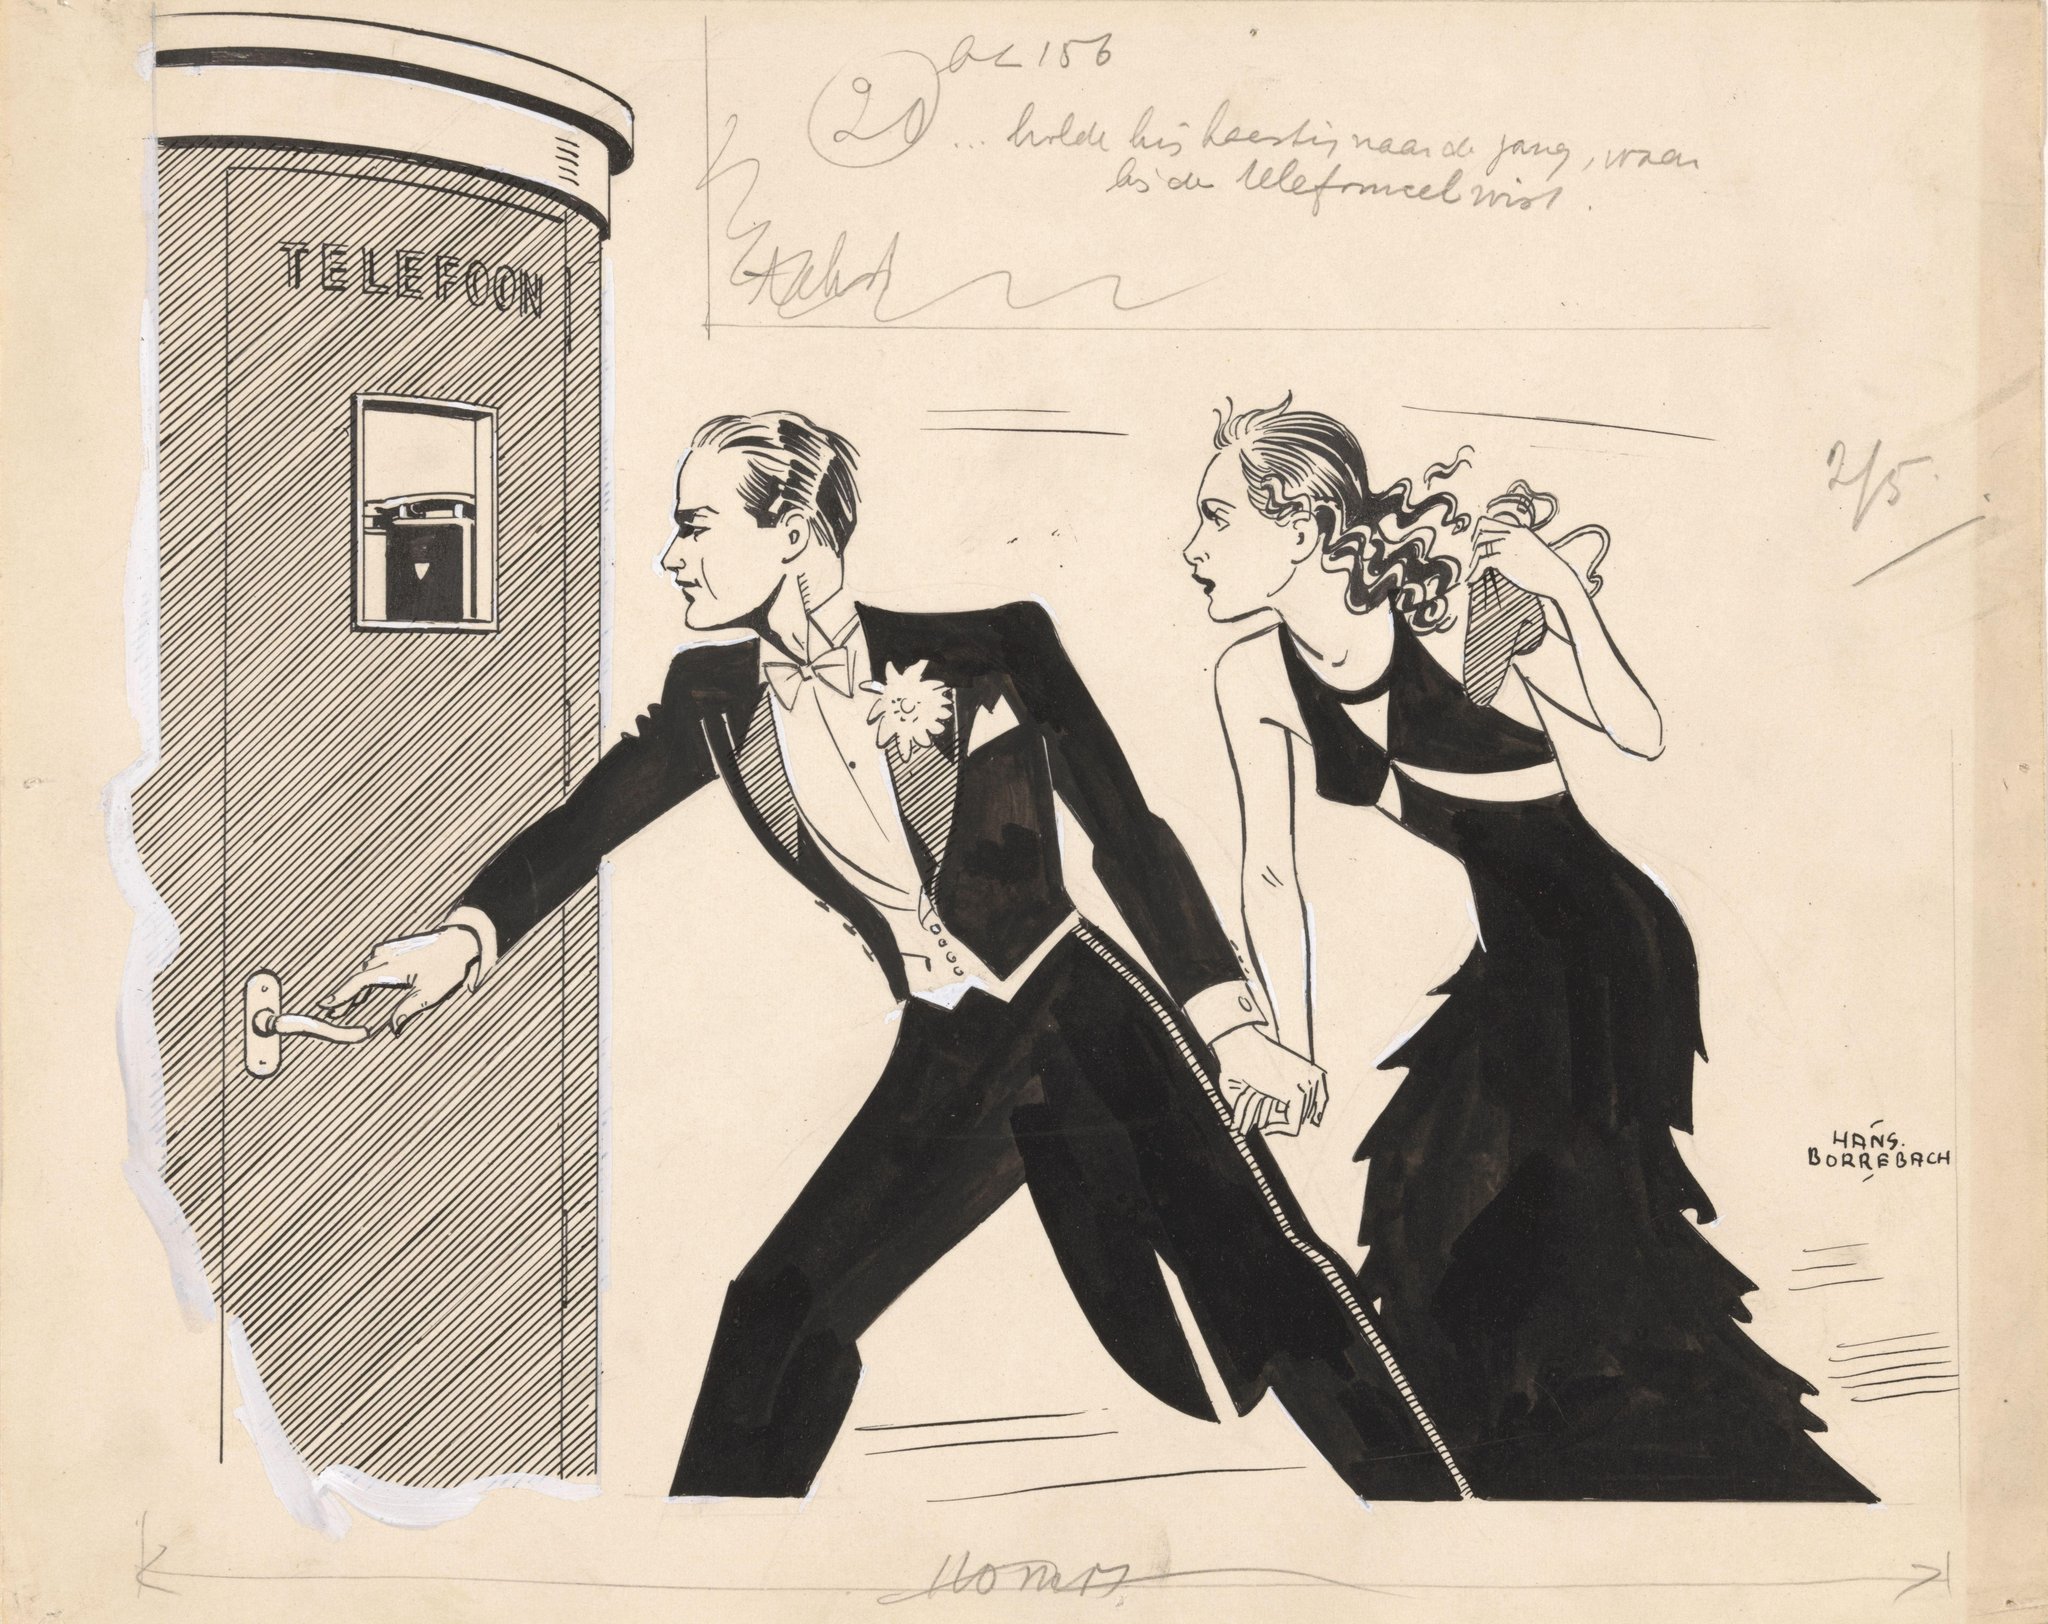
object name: boekillustratie ontwerp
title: Man holt met Pepita naar een telefooncel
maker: hans borrebach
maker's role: draughtsman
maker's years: 1903-1991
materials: paint, ink, paper, pencil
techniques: brush, pen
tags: dress, gown: evening dress (+ women's clothes), public call-box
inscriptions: :, annotation: ‘20 bz 156/ ...holde hij haastig naar de gang, waar/ hij de telefooncel wist.’, collector's mark: Lugt 2228a, signature: ‘HANS./ BORREBACH’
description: Een jonge man neemt Pepita bij de hand en holt met haar naar een telefooncel op een gang. Beide zijn gehuld in avondkleding.